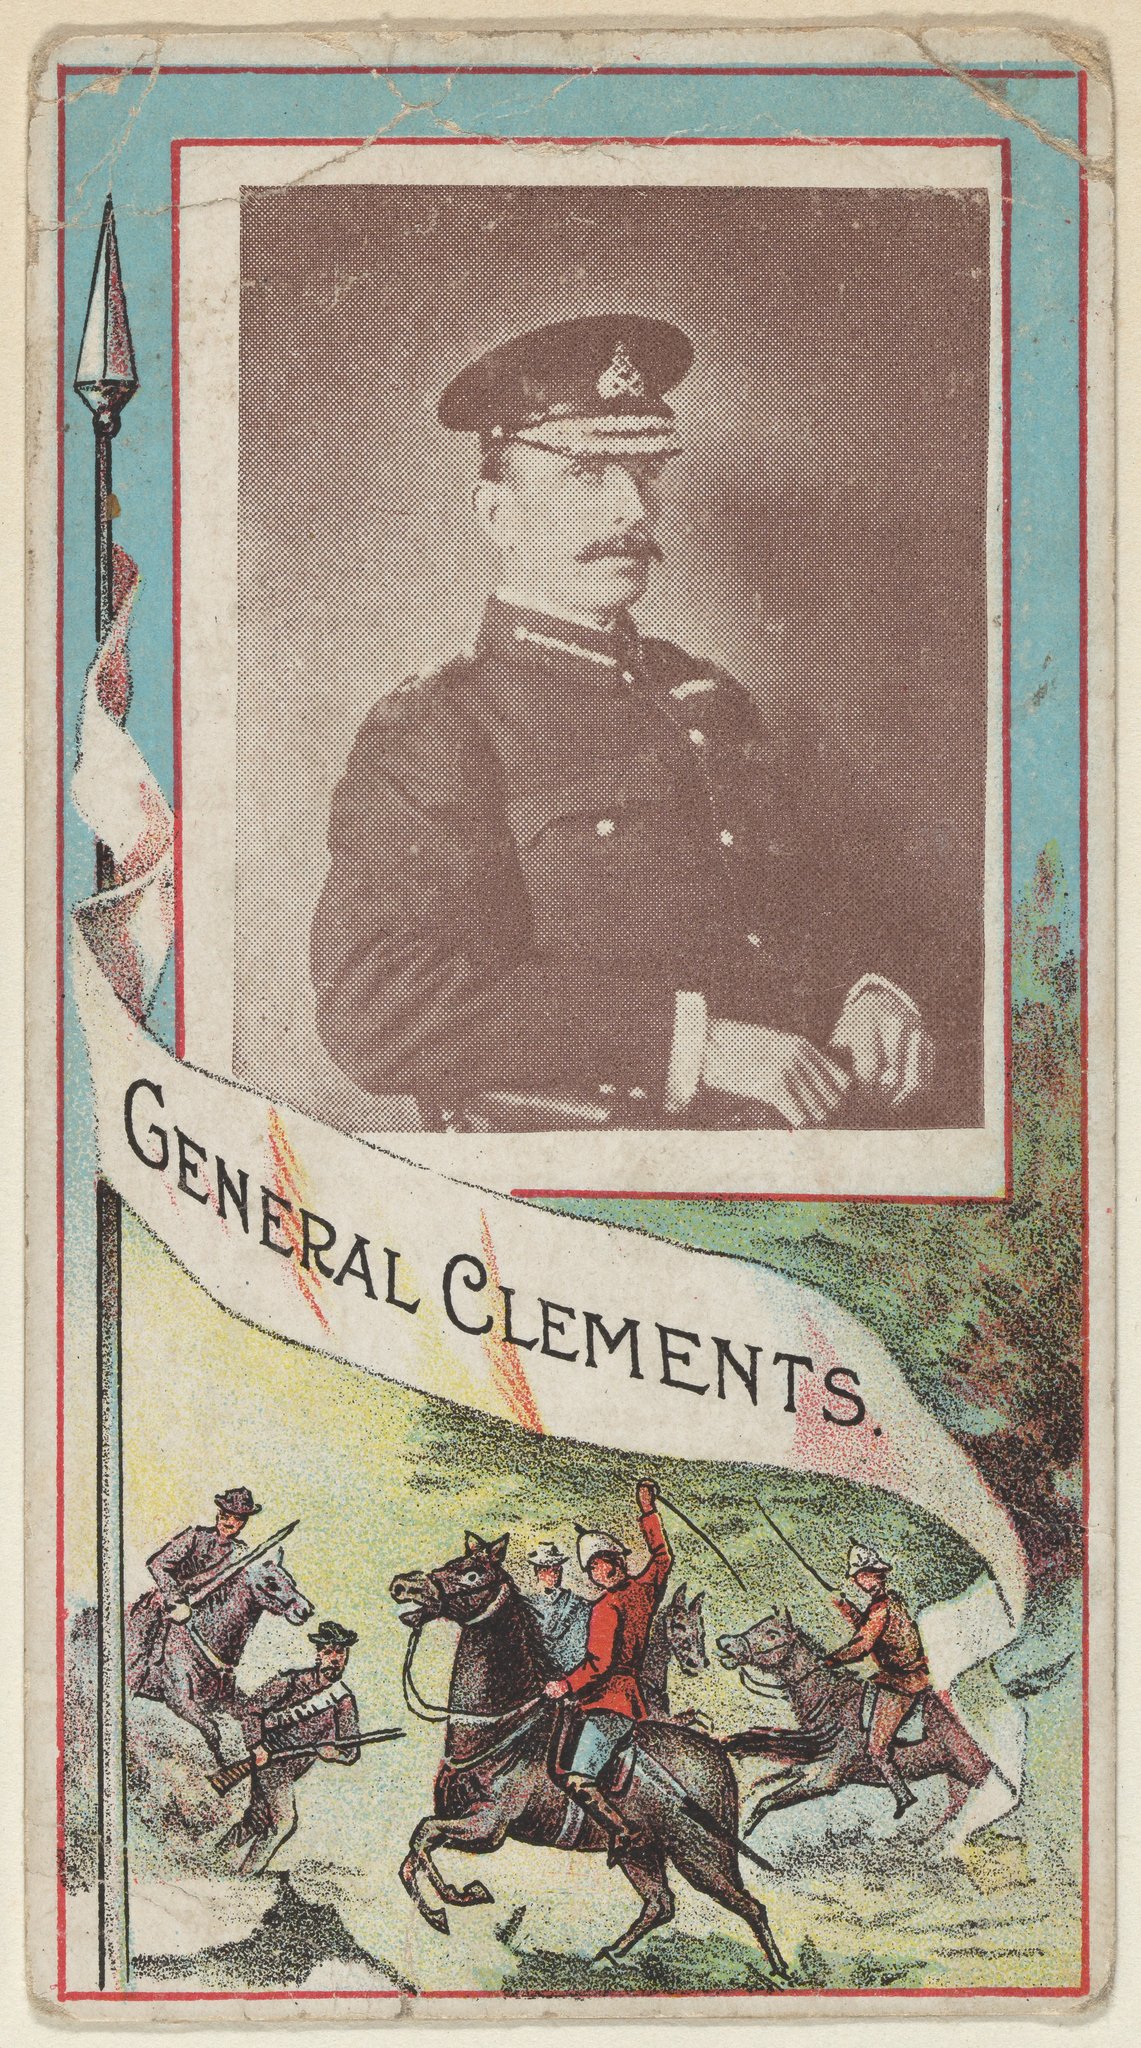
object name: print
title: General Clements, from the "Generals" series (T64), issued by D.H. McAlpin & Co. Tobacco Company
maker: d.h. mcalpin & co. tobacco company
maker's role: publisher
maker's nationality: american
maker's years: 1857-1901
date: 1901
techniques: color lithograph